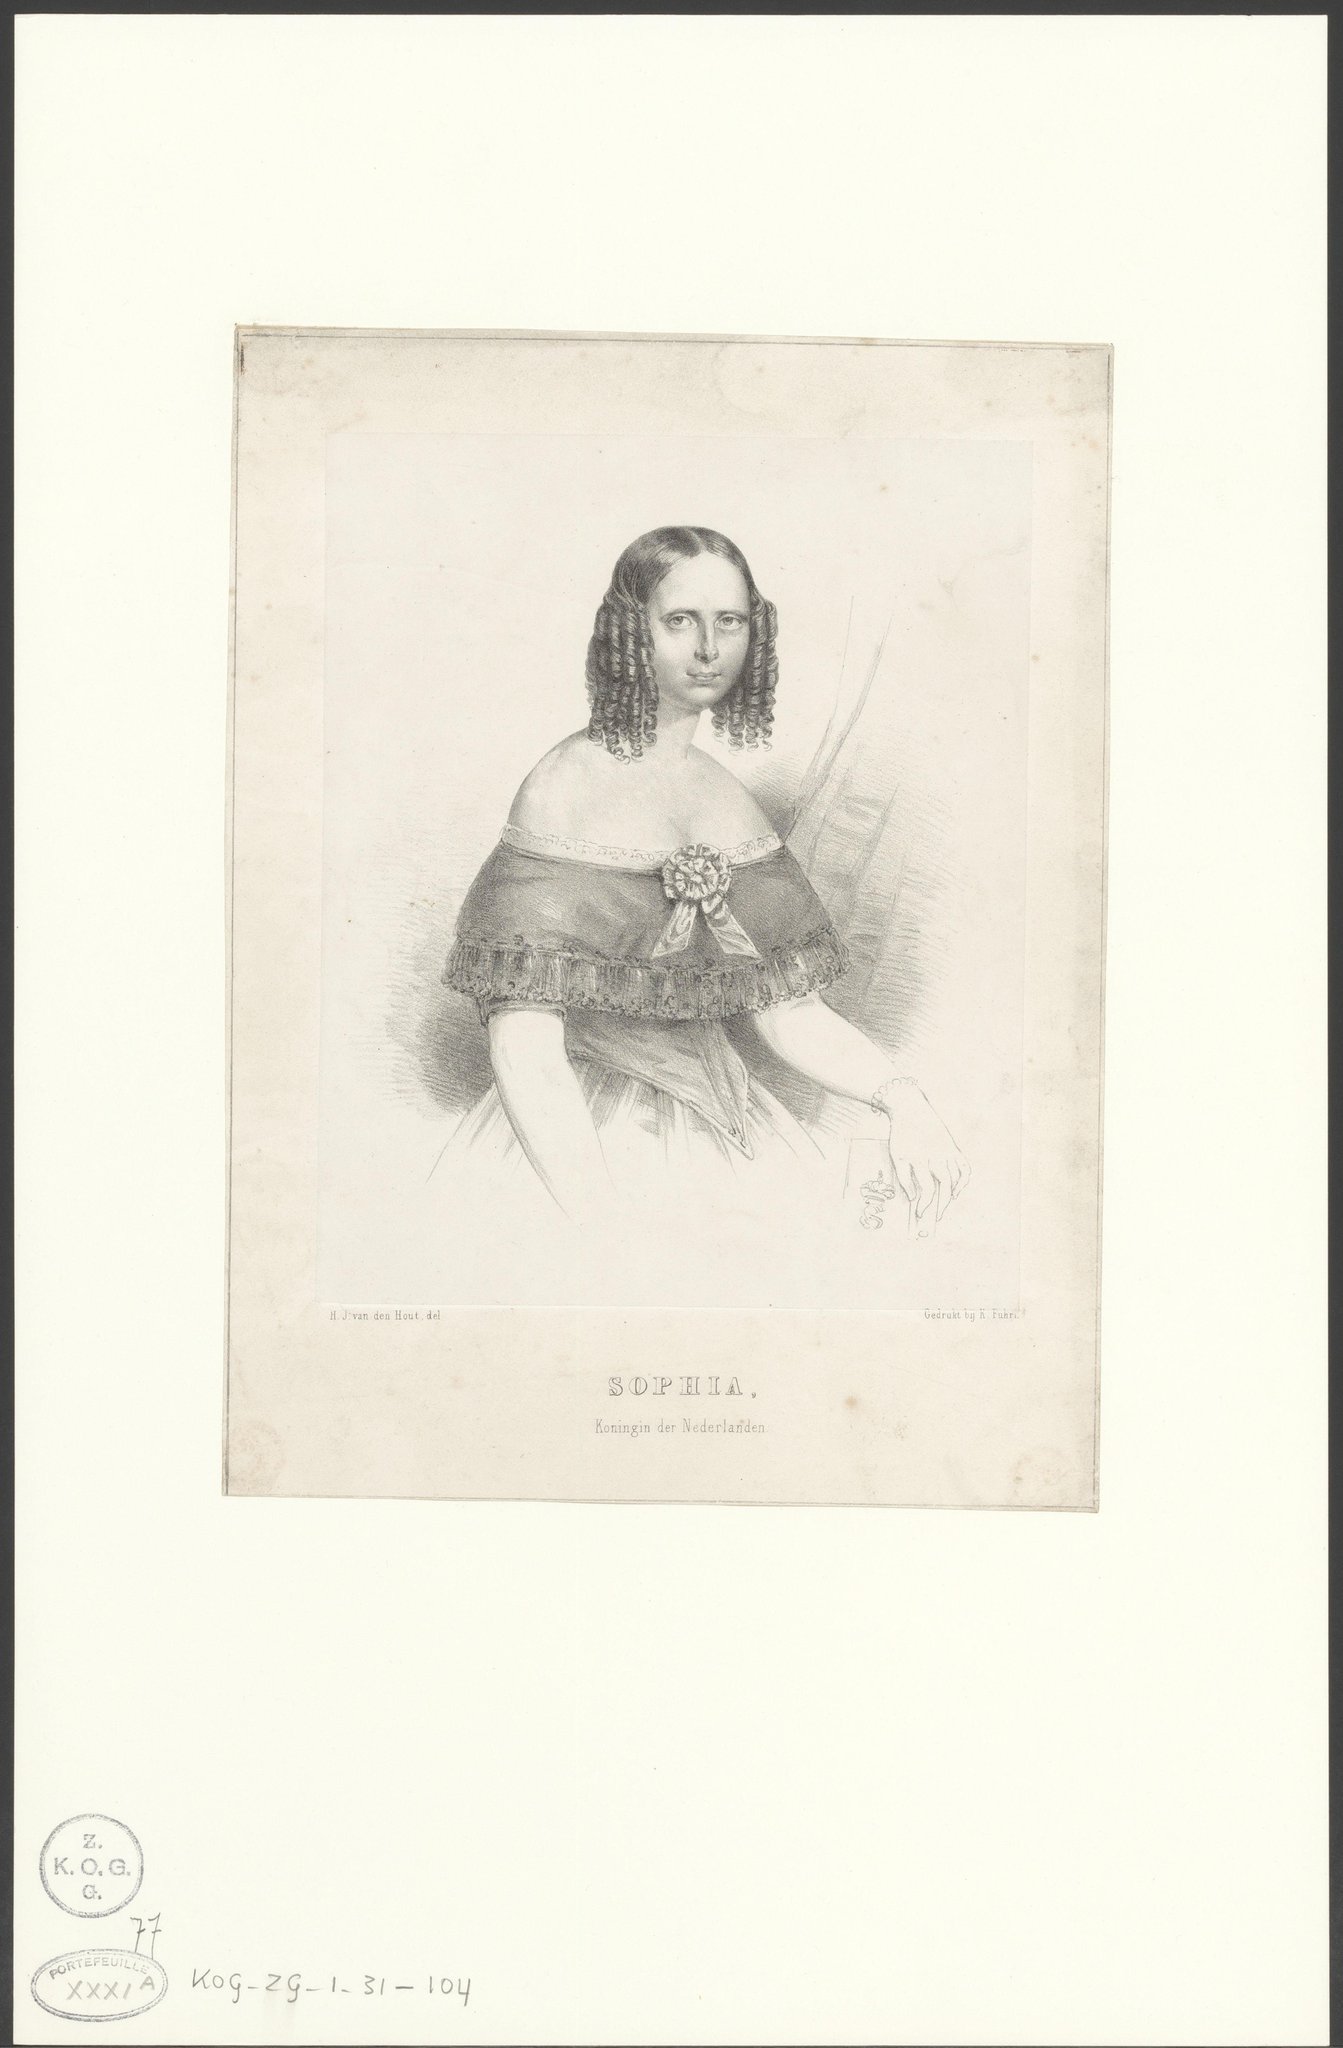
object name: print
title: Sophia Koningin der Nederlanden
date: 1849-1853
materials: paper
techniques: lithograph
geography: the hague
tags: the hague, sophia frederika mathilda van württemberg, historical persons - bb - woman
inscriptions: collector's mark: Lugt 1641, stamp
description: Onderwerpsrubrieken binnen de Atlas Zeden en Gewoonten: Portretten, Portretten van Vorsten uit het huis van Oranje, Regeerende Vorsten, Koningen uit het huis van Oranje.